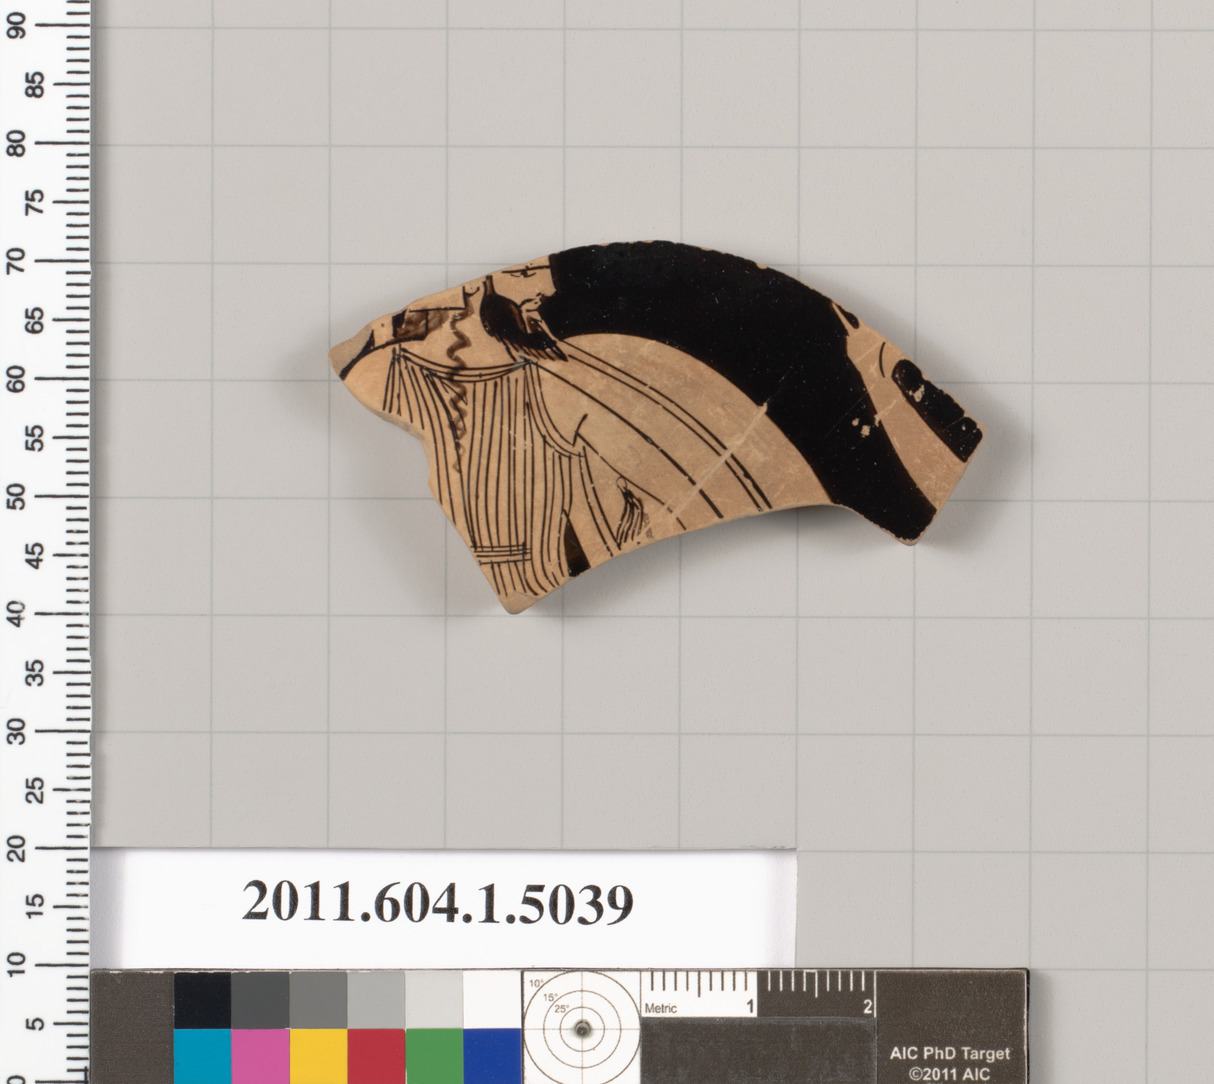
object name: kylix fragment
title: Terracotta fragment of a kylix (drinking cup)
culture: greek, attic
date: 475-451 BCE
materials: terracotta